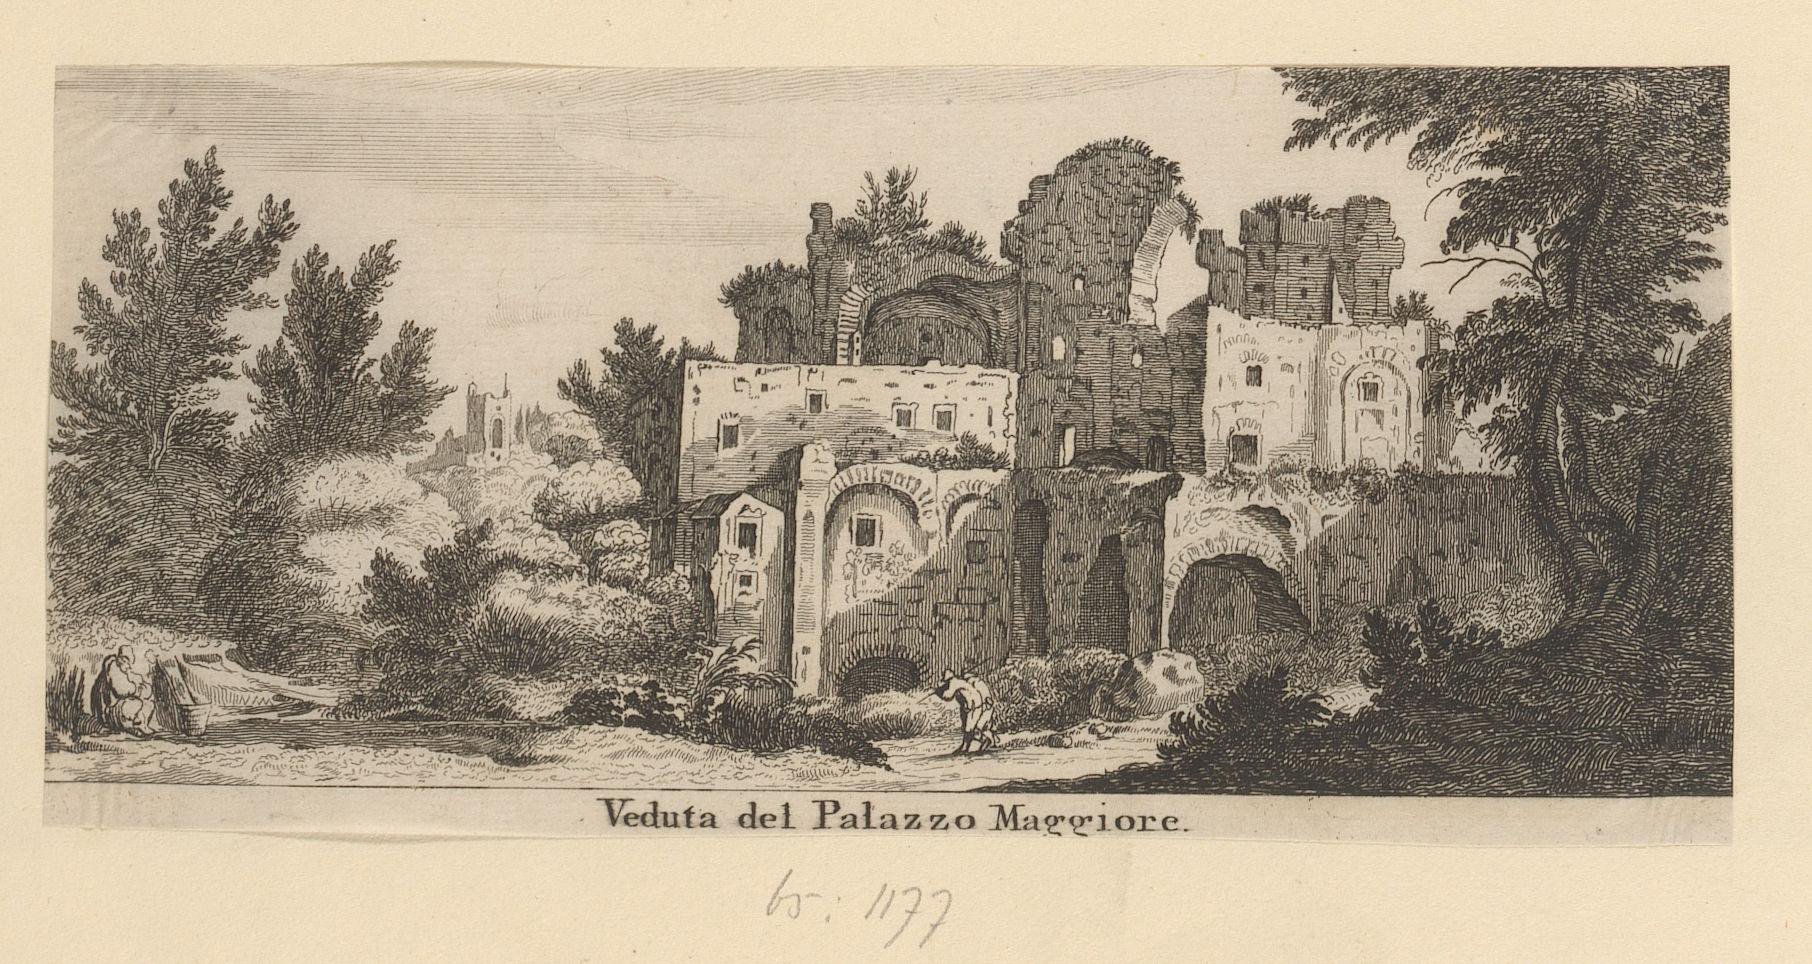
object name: album leaf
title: Veduta del Palazzo Maggiore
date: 1638-1799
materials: paper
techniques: etching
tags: landscape with ruins (+ city(-scape) with figures, staffage)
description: Prent maakt mogelijk deel uit van een serie van 200 prenten. Deze serie is onder de titel 'A Collection of two hundred original etchings' voor het eerst uitgegeven door J.M. Greery in 1816.